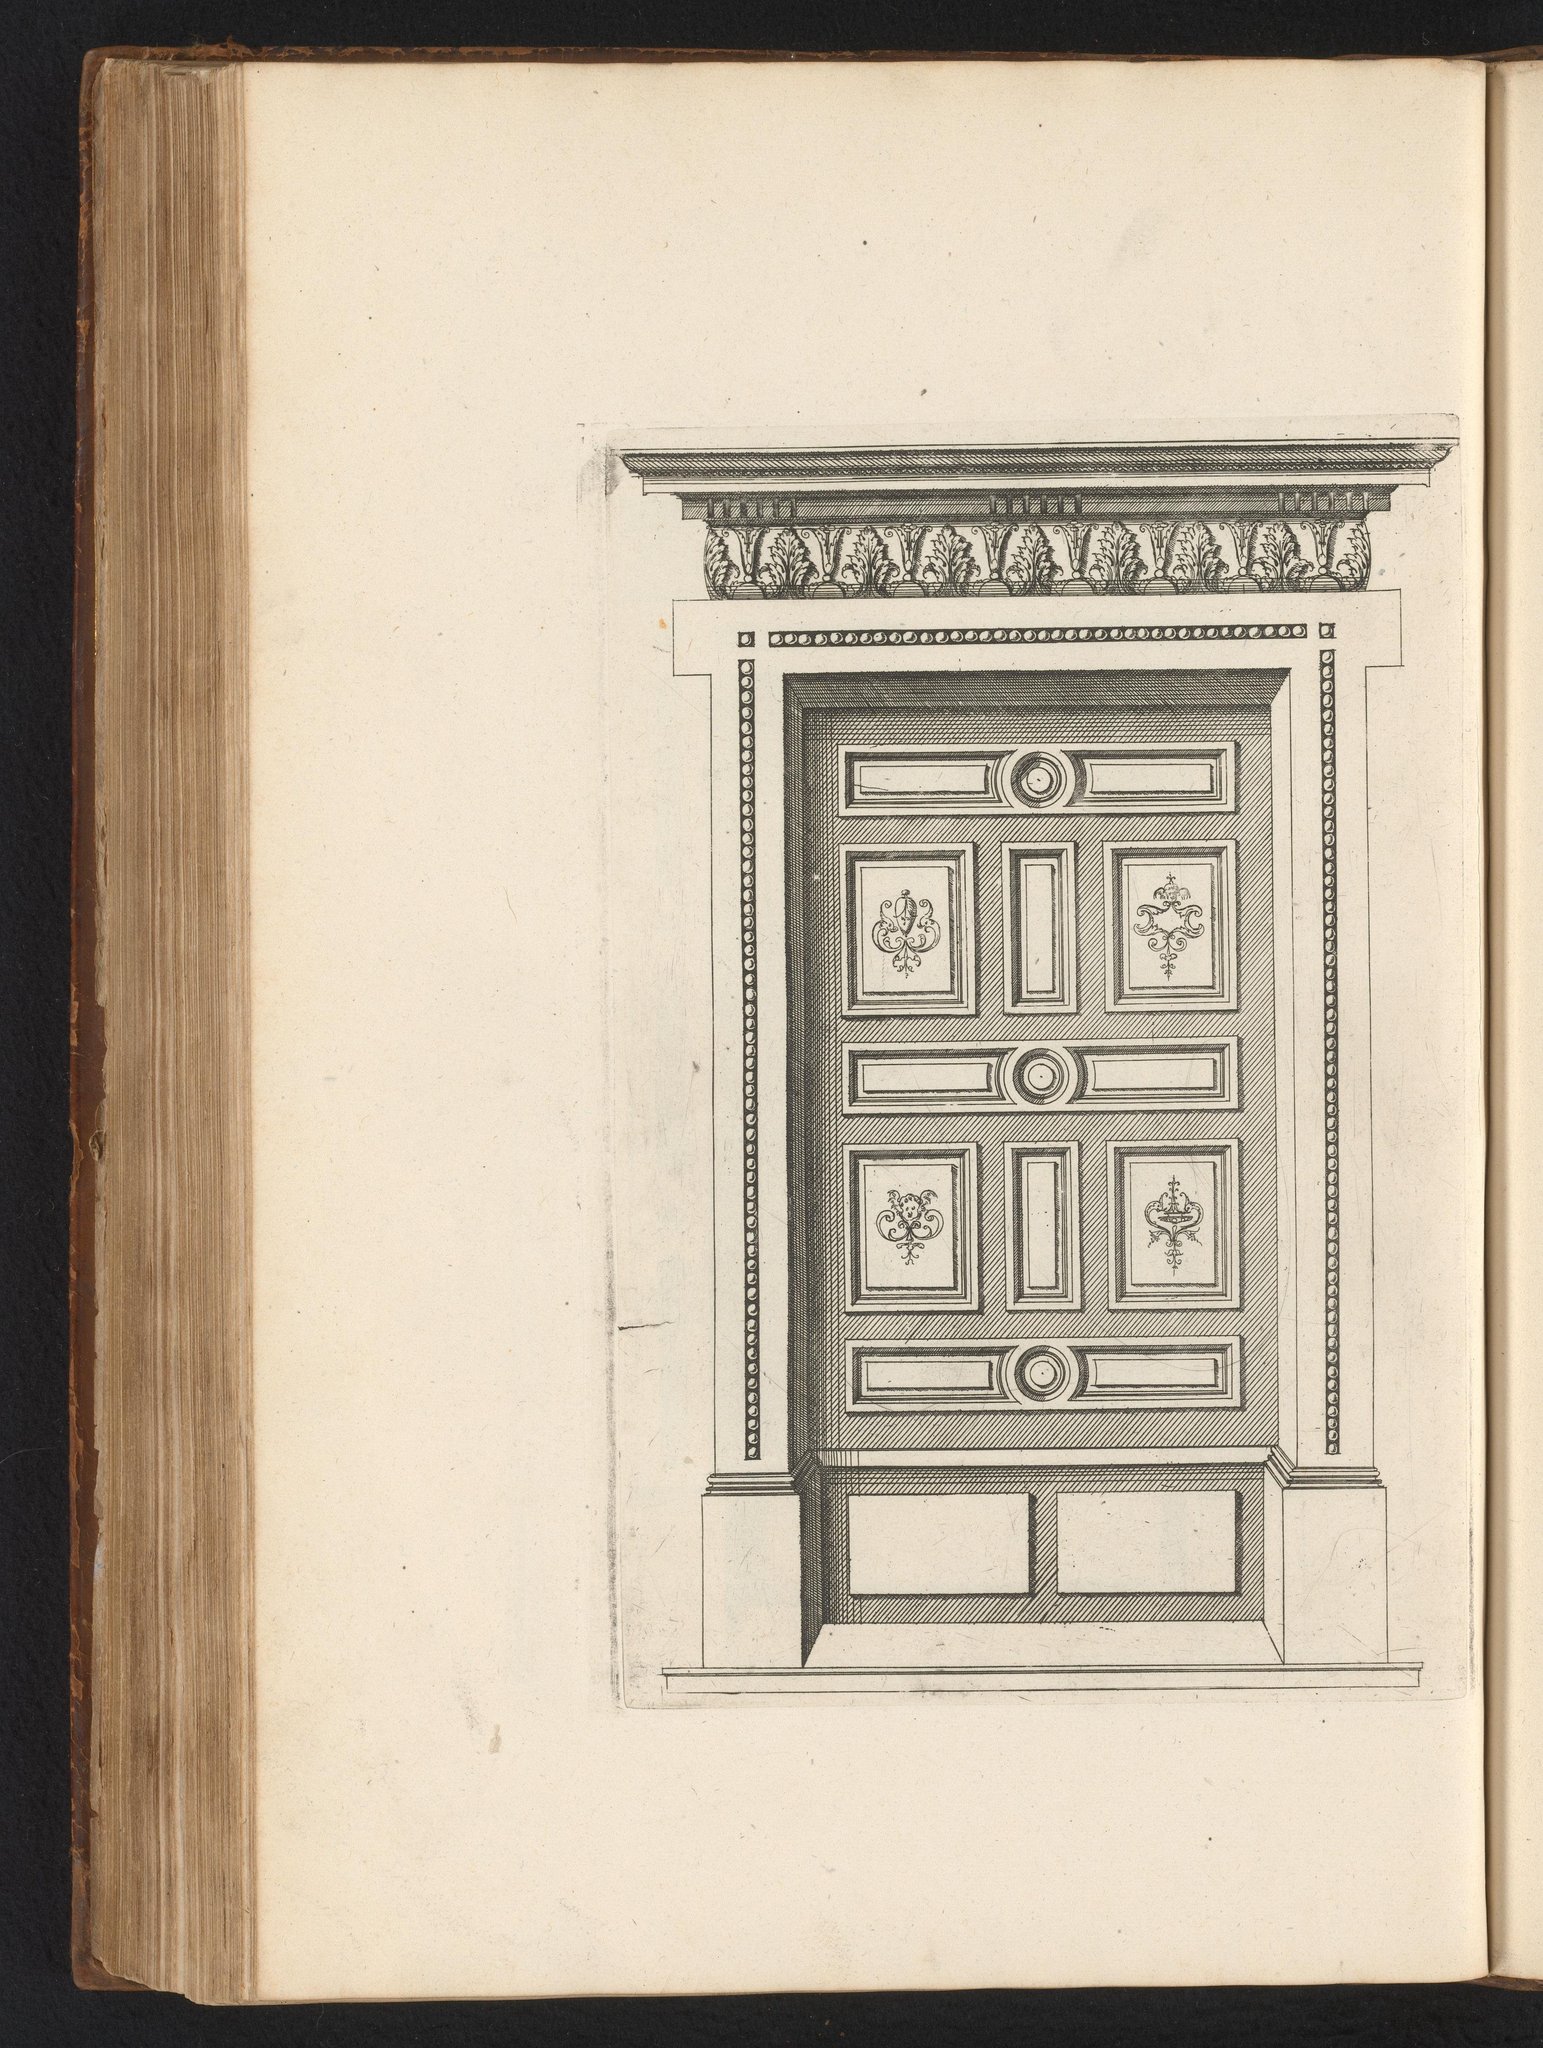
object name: ornament print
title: Deur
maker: jacques androuet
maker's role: draughtsman, print maker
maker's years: 1515-1584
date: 1561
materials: paper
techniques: etching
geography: paris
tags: door, architectural design or model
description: Deur versierd met grotesken. Onderdeel van 'Seconde livre d'architectvre' (1561): 64 etsen met geornamenteerde architectuuronderdelen.